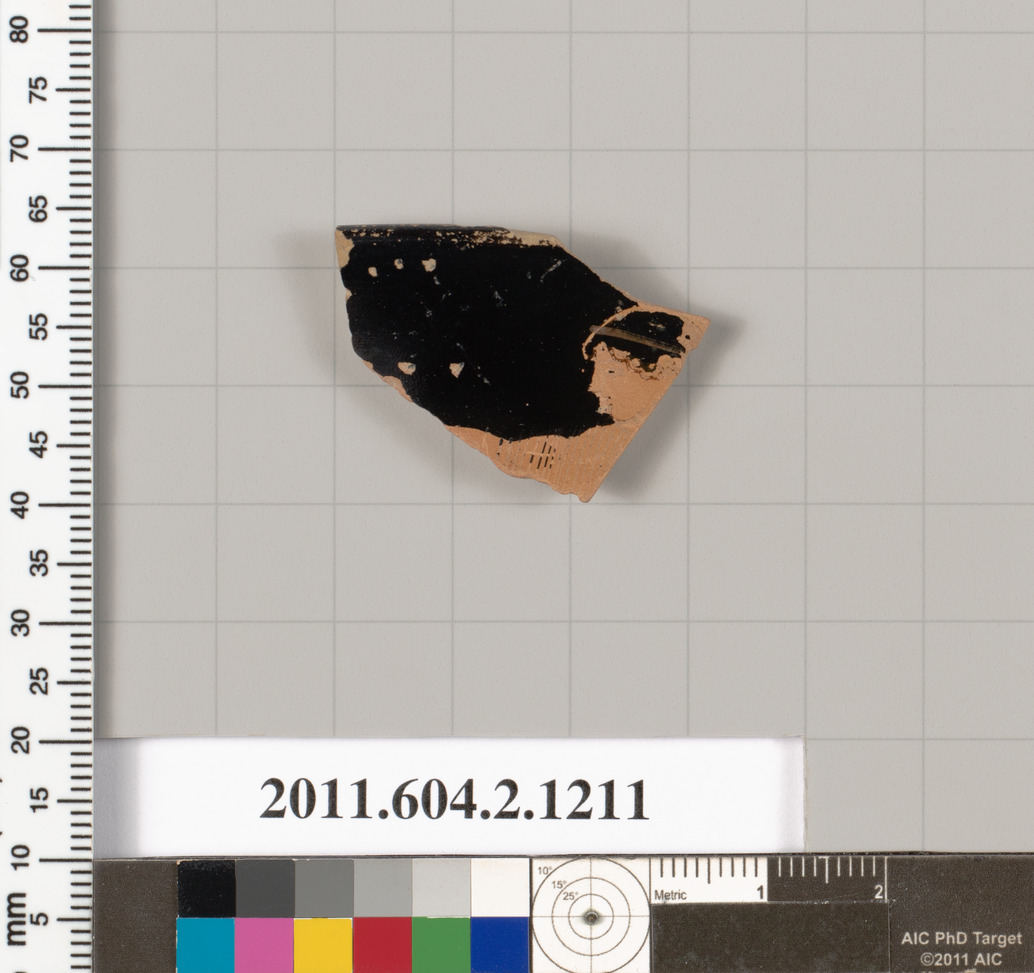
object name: kantharos fragment, head vase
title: Terracotta fragment from a kantharos: head vase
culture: greek, attic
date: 460-450 BCE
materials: terracotta